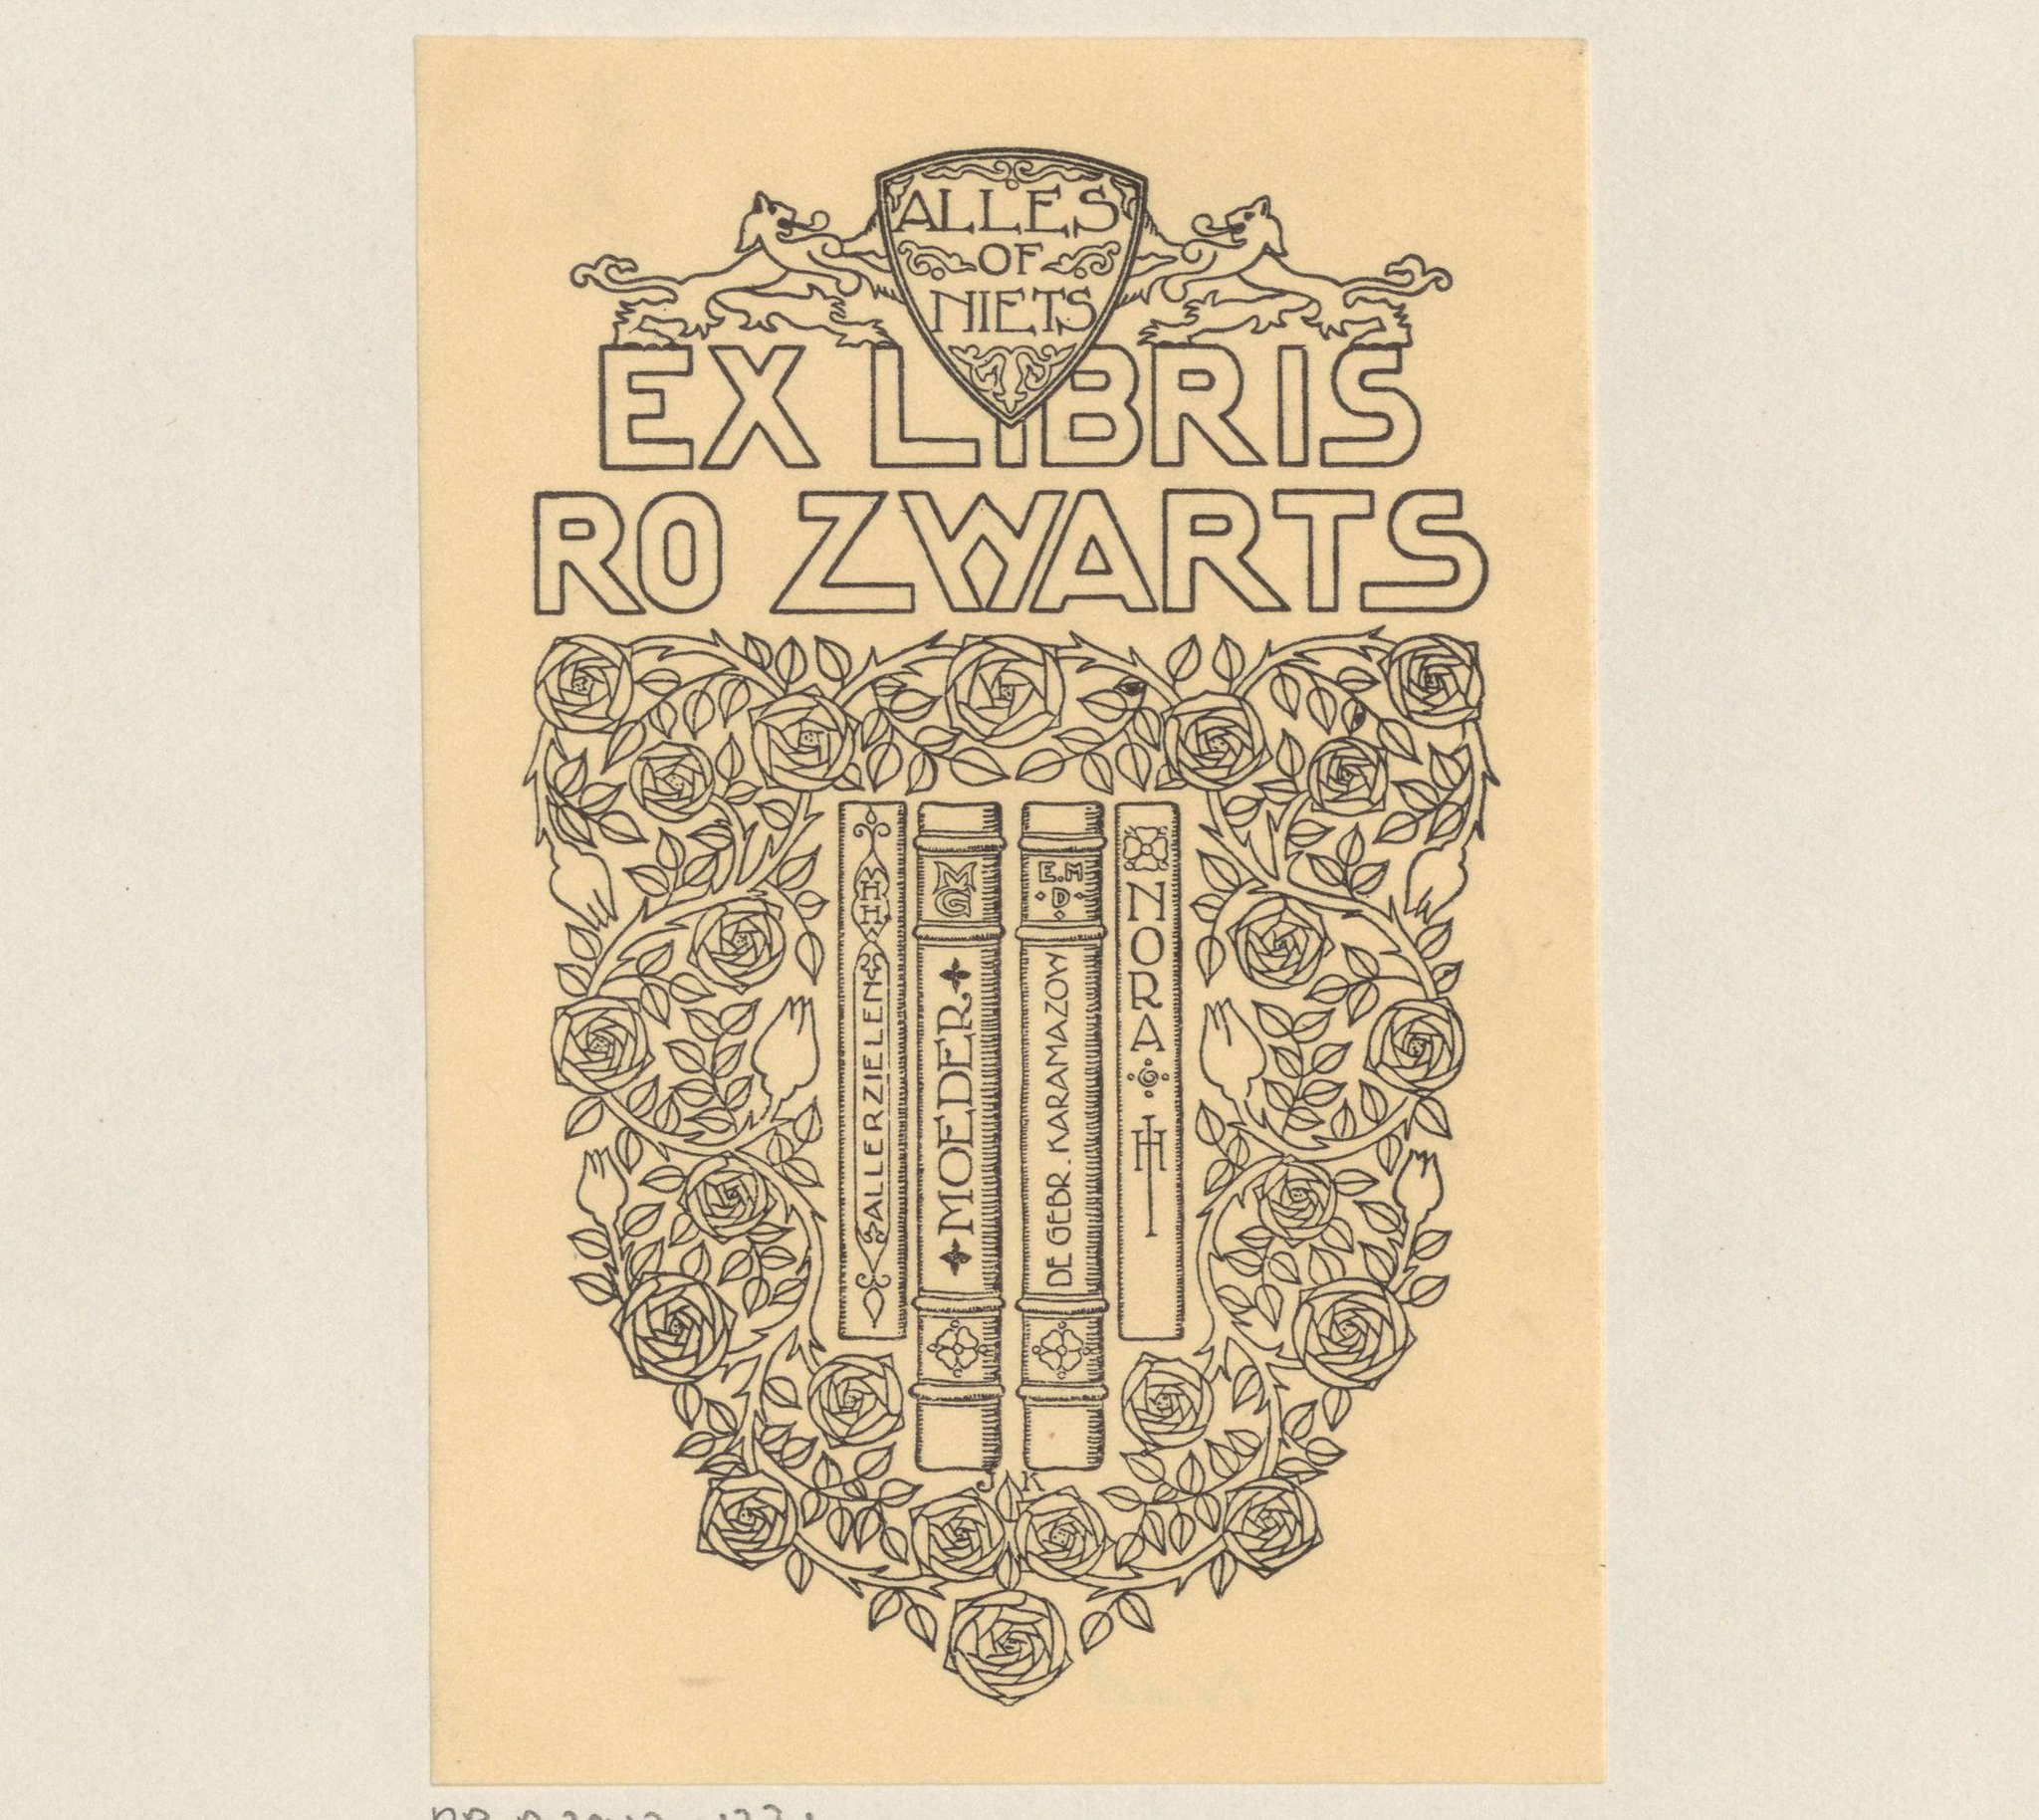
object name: bookplate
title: Ex libris van Ro Zwarts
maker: Anonymous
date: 1935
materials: paper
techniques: printing block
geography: netherlands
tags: shrubs: rose-bush, book, armorial bearing, heraldry